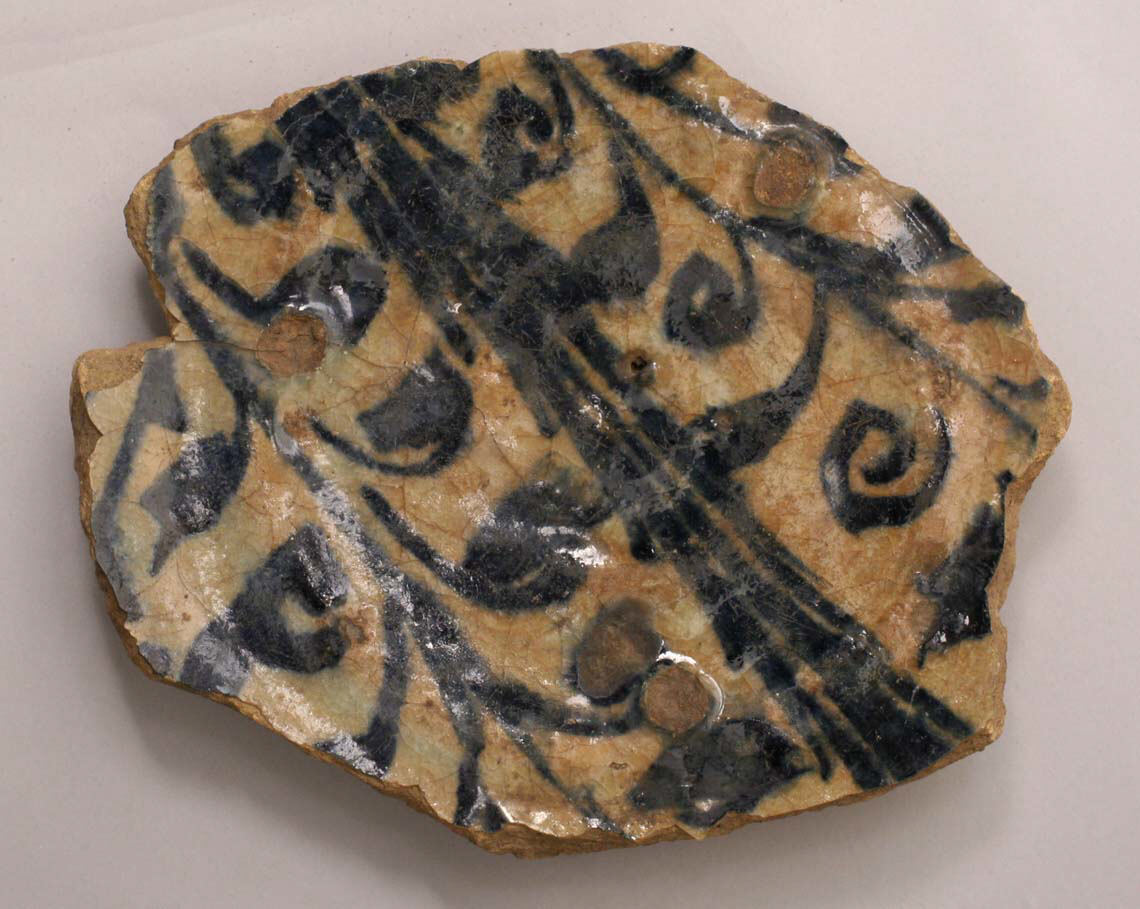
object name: fragment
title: Ceramic Fragment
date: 1401-1500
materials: glaze, stonepaste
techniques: painting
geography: egypt